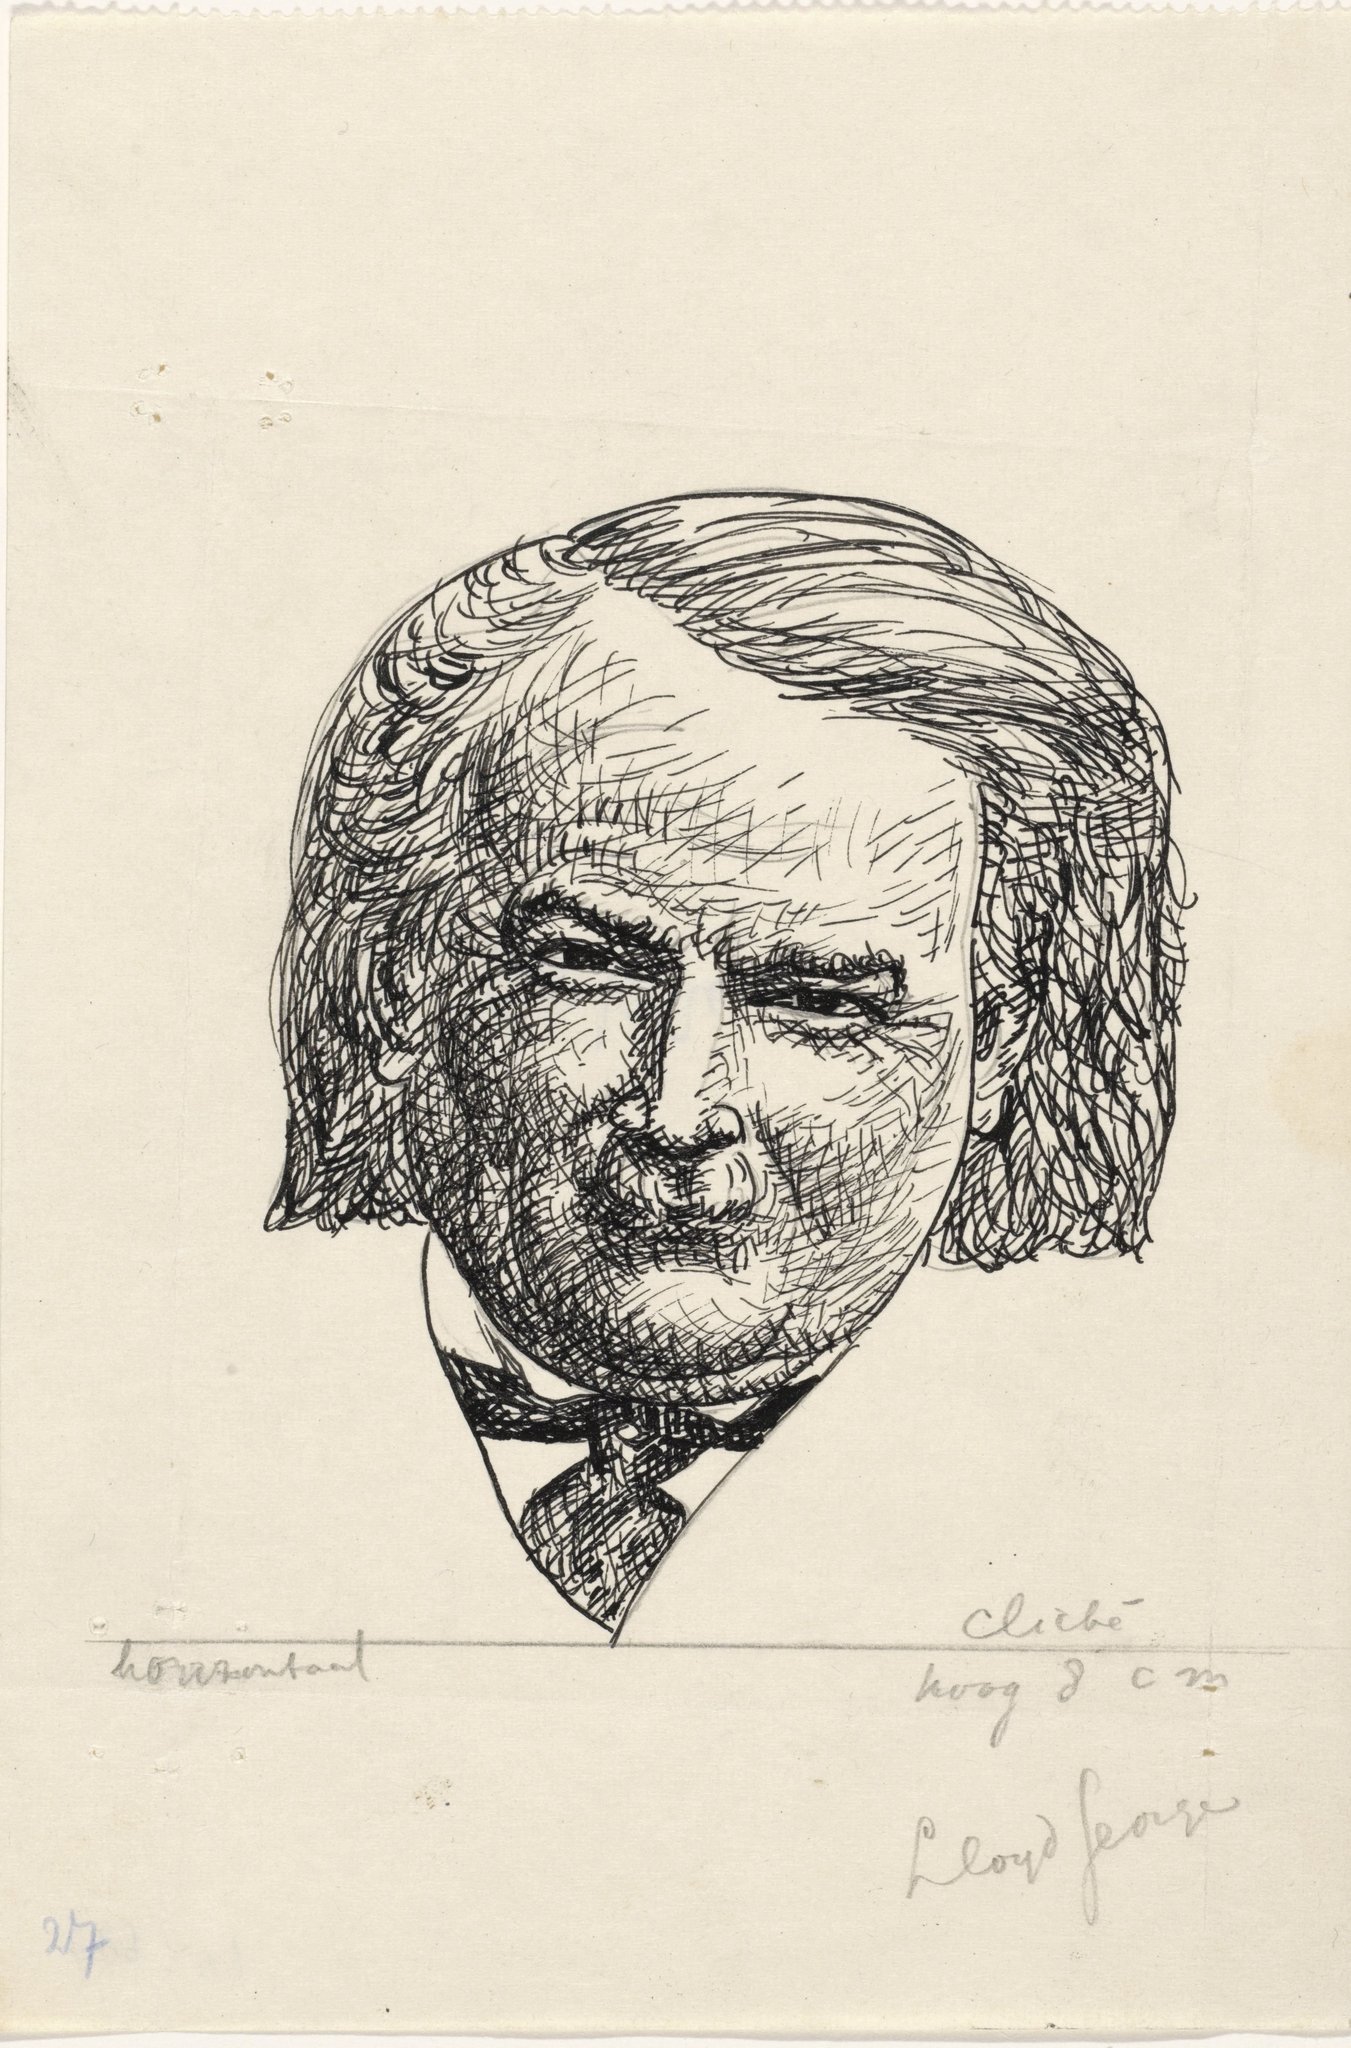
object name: boekillustratie ontwerp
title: Portret van David Lloyd George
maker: leo gestel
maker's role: draughtsman, print maker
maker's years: 1881-1941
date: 1934-1936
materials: ink, paper, pencil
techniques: pen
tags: (cohen, van anarchist tot monarchist) specific works of literature (with author, title), historical persons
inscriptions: clichéaanwijzing, recto, handgeschreven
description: Ontwerp voor een boekillustratie voor: Cohen, Alexander. Van anarchist tot monarchist. Amsterdam: De Steenuil, 1936.